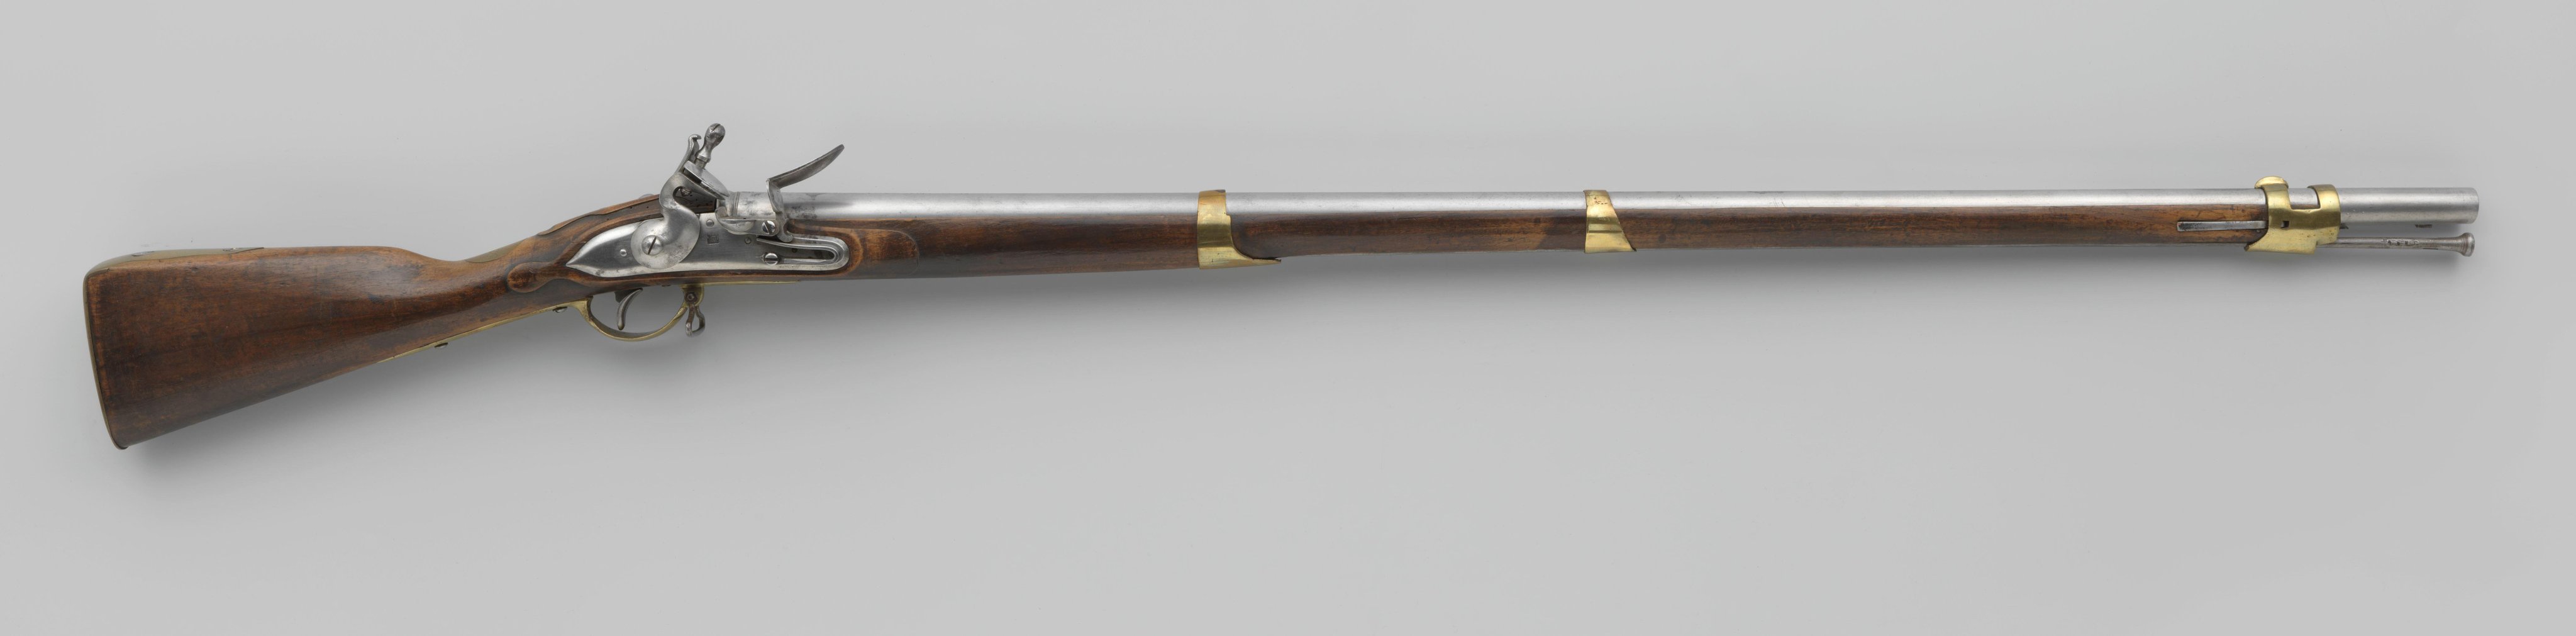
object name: rifle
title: Geweer van de Admiraliteit op de Maas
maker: Anonymous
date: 1700-1800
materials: brass, iron, wood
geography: netherlands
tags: admiraliteit van rotterdam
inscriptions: mark: ‘KULENBURG’, : ‘ADMIRt OP DE MAAS’, : ‘wapenschild met 3 diabolo-vormige tekens, 2 boven en 1 onder, gekroond’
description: Geweer met vuursteenslot, bajonet, ijzeren laadstok en koperen montuur. Met opschrift: ADMIRt OP DE MAAS. Een der merken Culenburg. In gebruik geweest bij de marine.